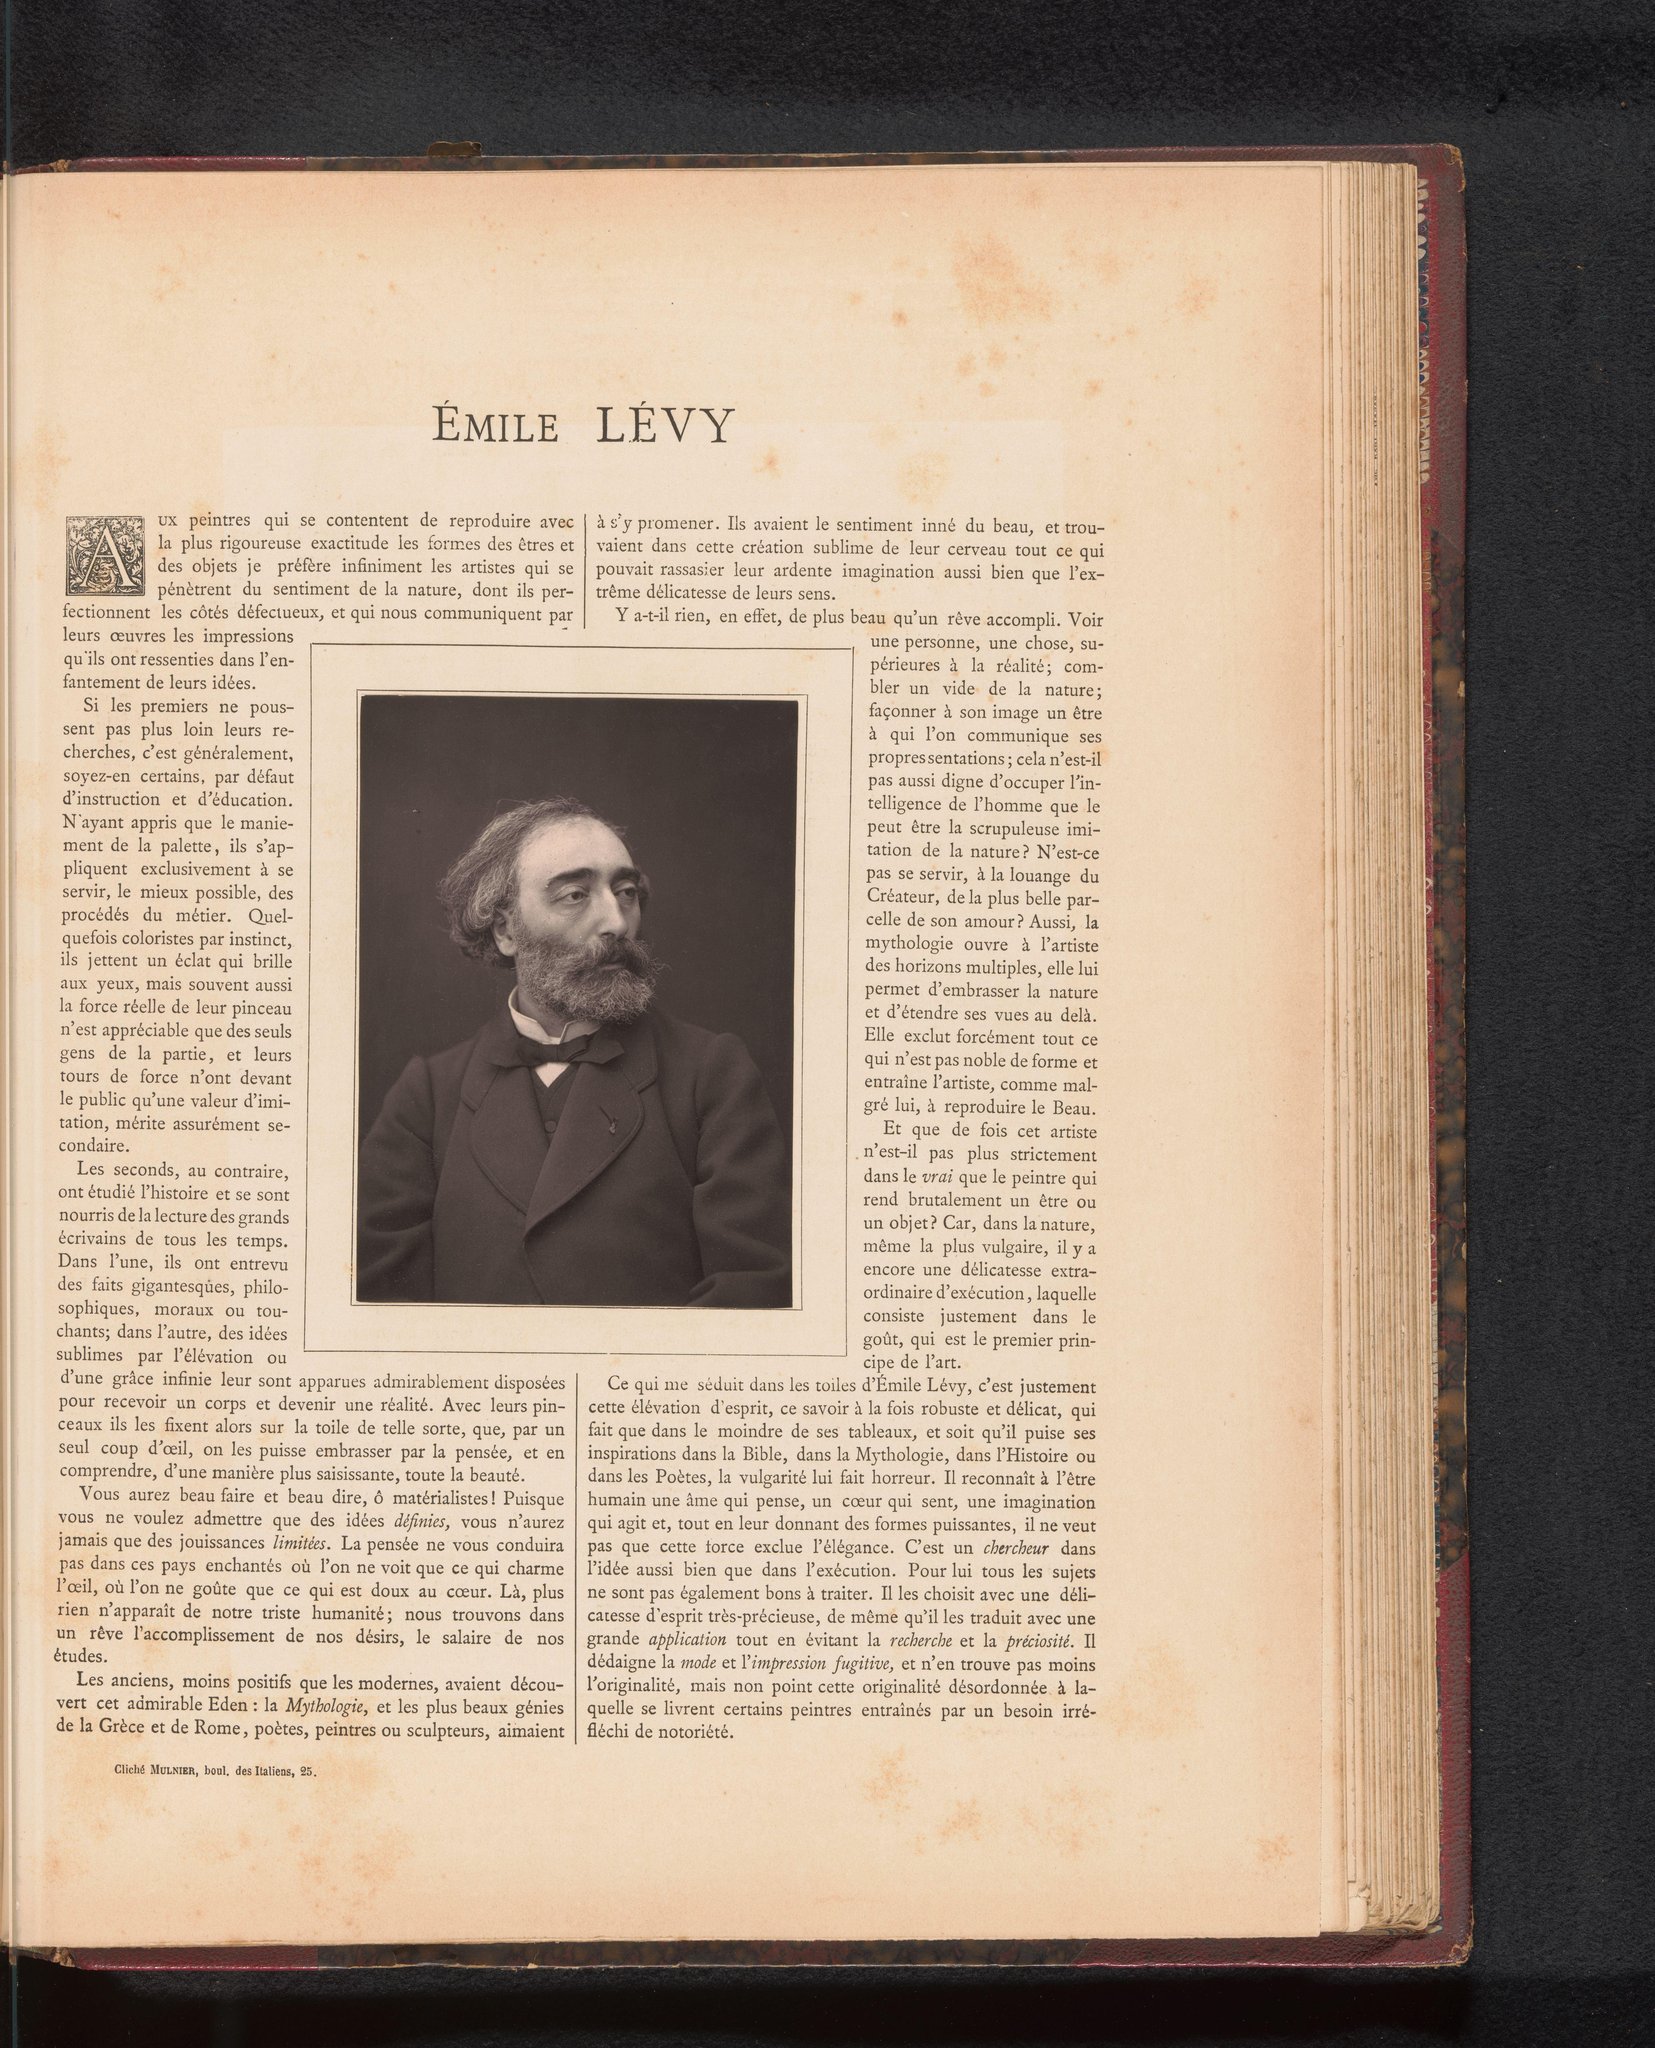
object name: page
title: Émile Lévy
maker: ferdinand mulnier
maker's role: painter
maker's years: 1817-1891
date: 1873-1878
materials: paper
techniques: woodburytype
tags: paris, painter, emile lévy, adult man, historical persons